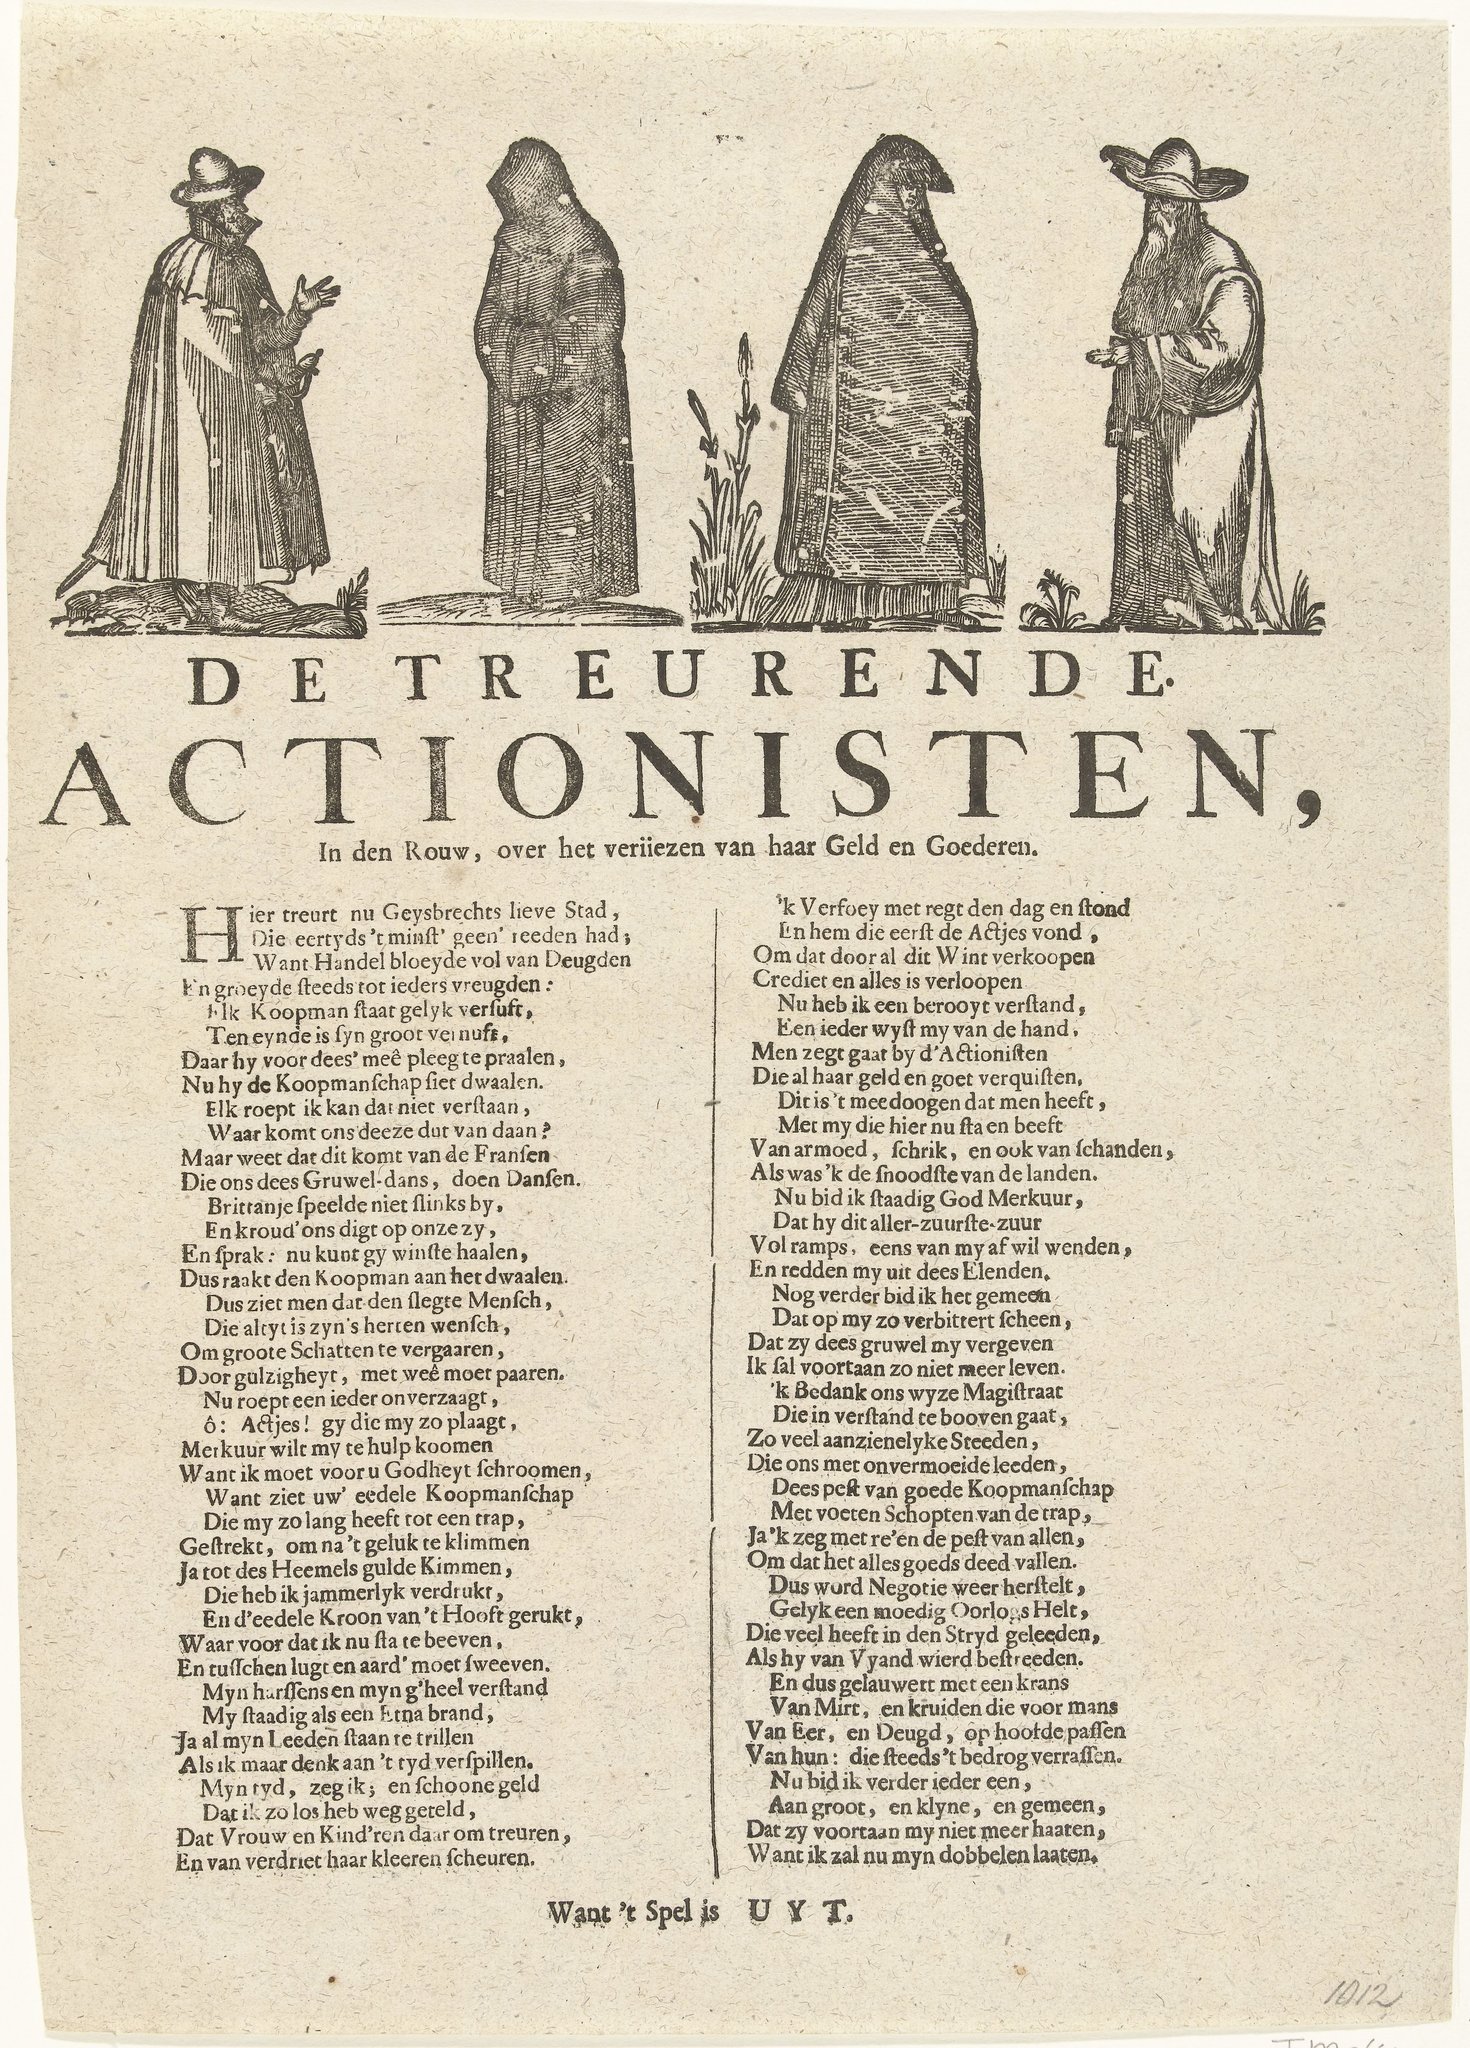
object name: cartoon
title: De Treurende Actionisten, In den Rouw, over het veriiezen van haar Geld en Goederen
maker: Anonymous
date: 1720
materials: paper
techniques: letterpress printing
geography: northern netherlands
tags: mourning the dead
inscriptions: collector's mark: Lugt 2228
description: De treurende actionisten. Blad met een spotvers op de actionisten die hun geld en goederen bij het speculeren in de windhandel verloren hebben. Bovenaan vier vier figuren zogenaamd in rouwkleding. Behoort tot de groep van bijprenten toegevoegd aan de serie Tafereel der Dwaasheid met spotprenten op de Windhandel of Actiehandel van 1720.